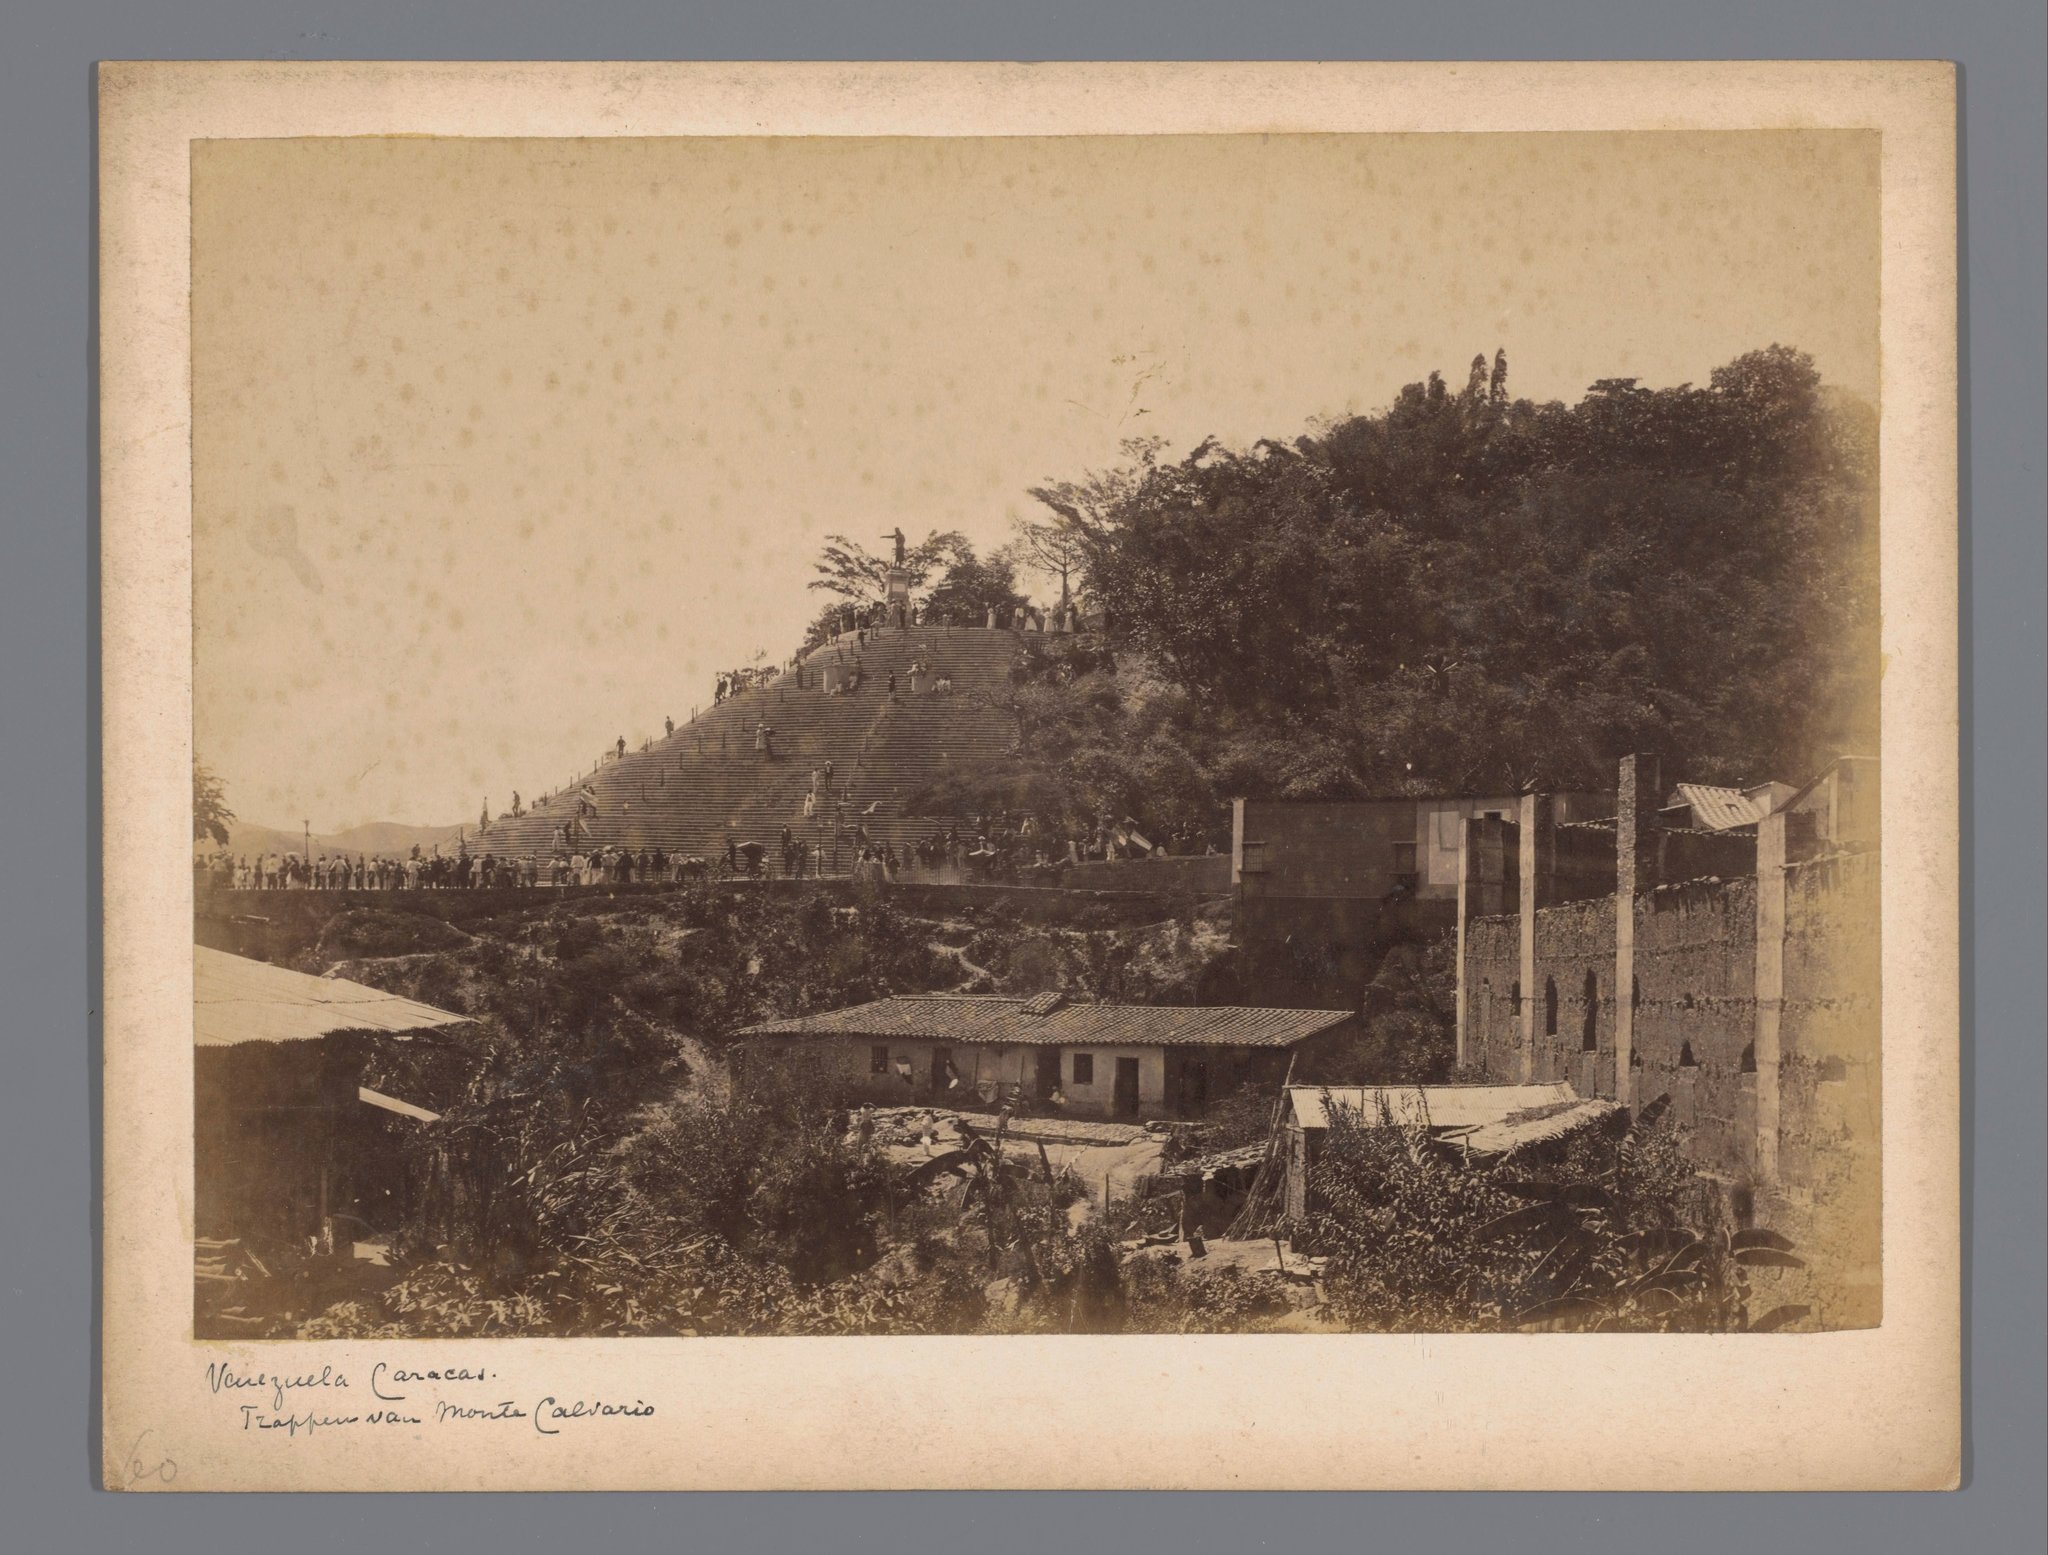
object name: photograph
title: Venezuela, Caracas, trappen van Monte Calvario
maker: Anonymous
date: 1898-1910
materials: cardboard, paper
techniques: albumen print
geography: caracas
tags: flight of steps, public gardens, park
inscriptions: number: ‘60’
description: Het standbeeld bovenaan de Escalinatas is vermoedelijk van Christoffel Columbus.